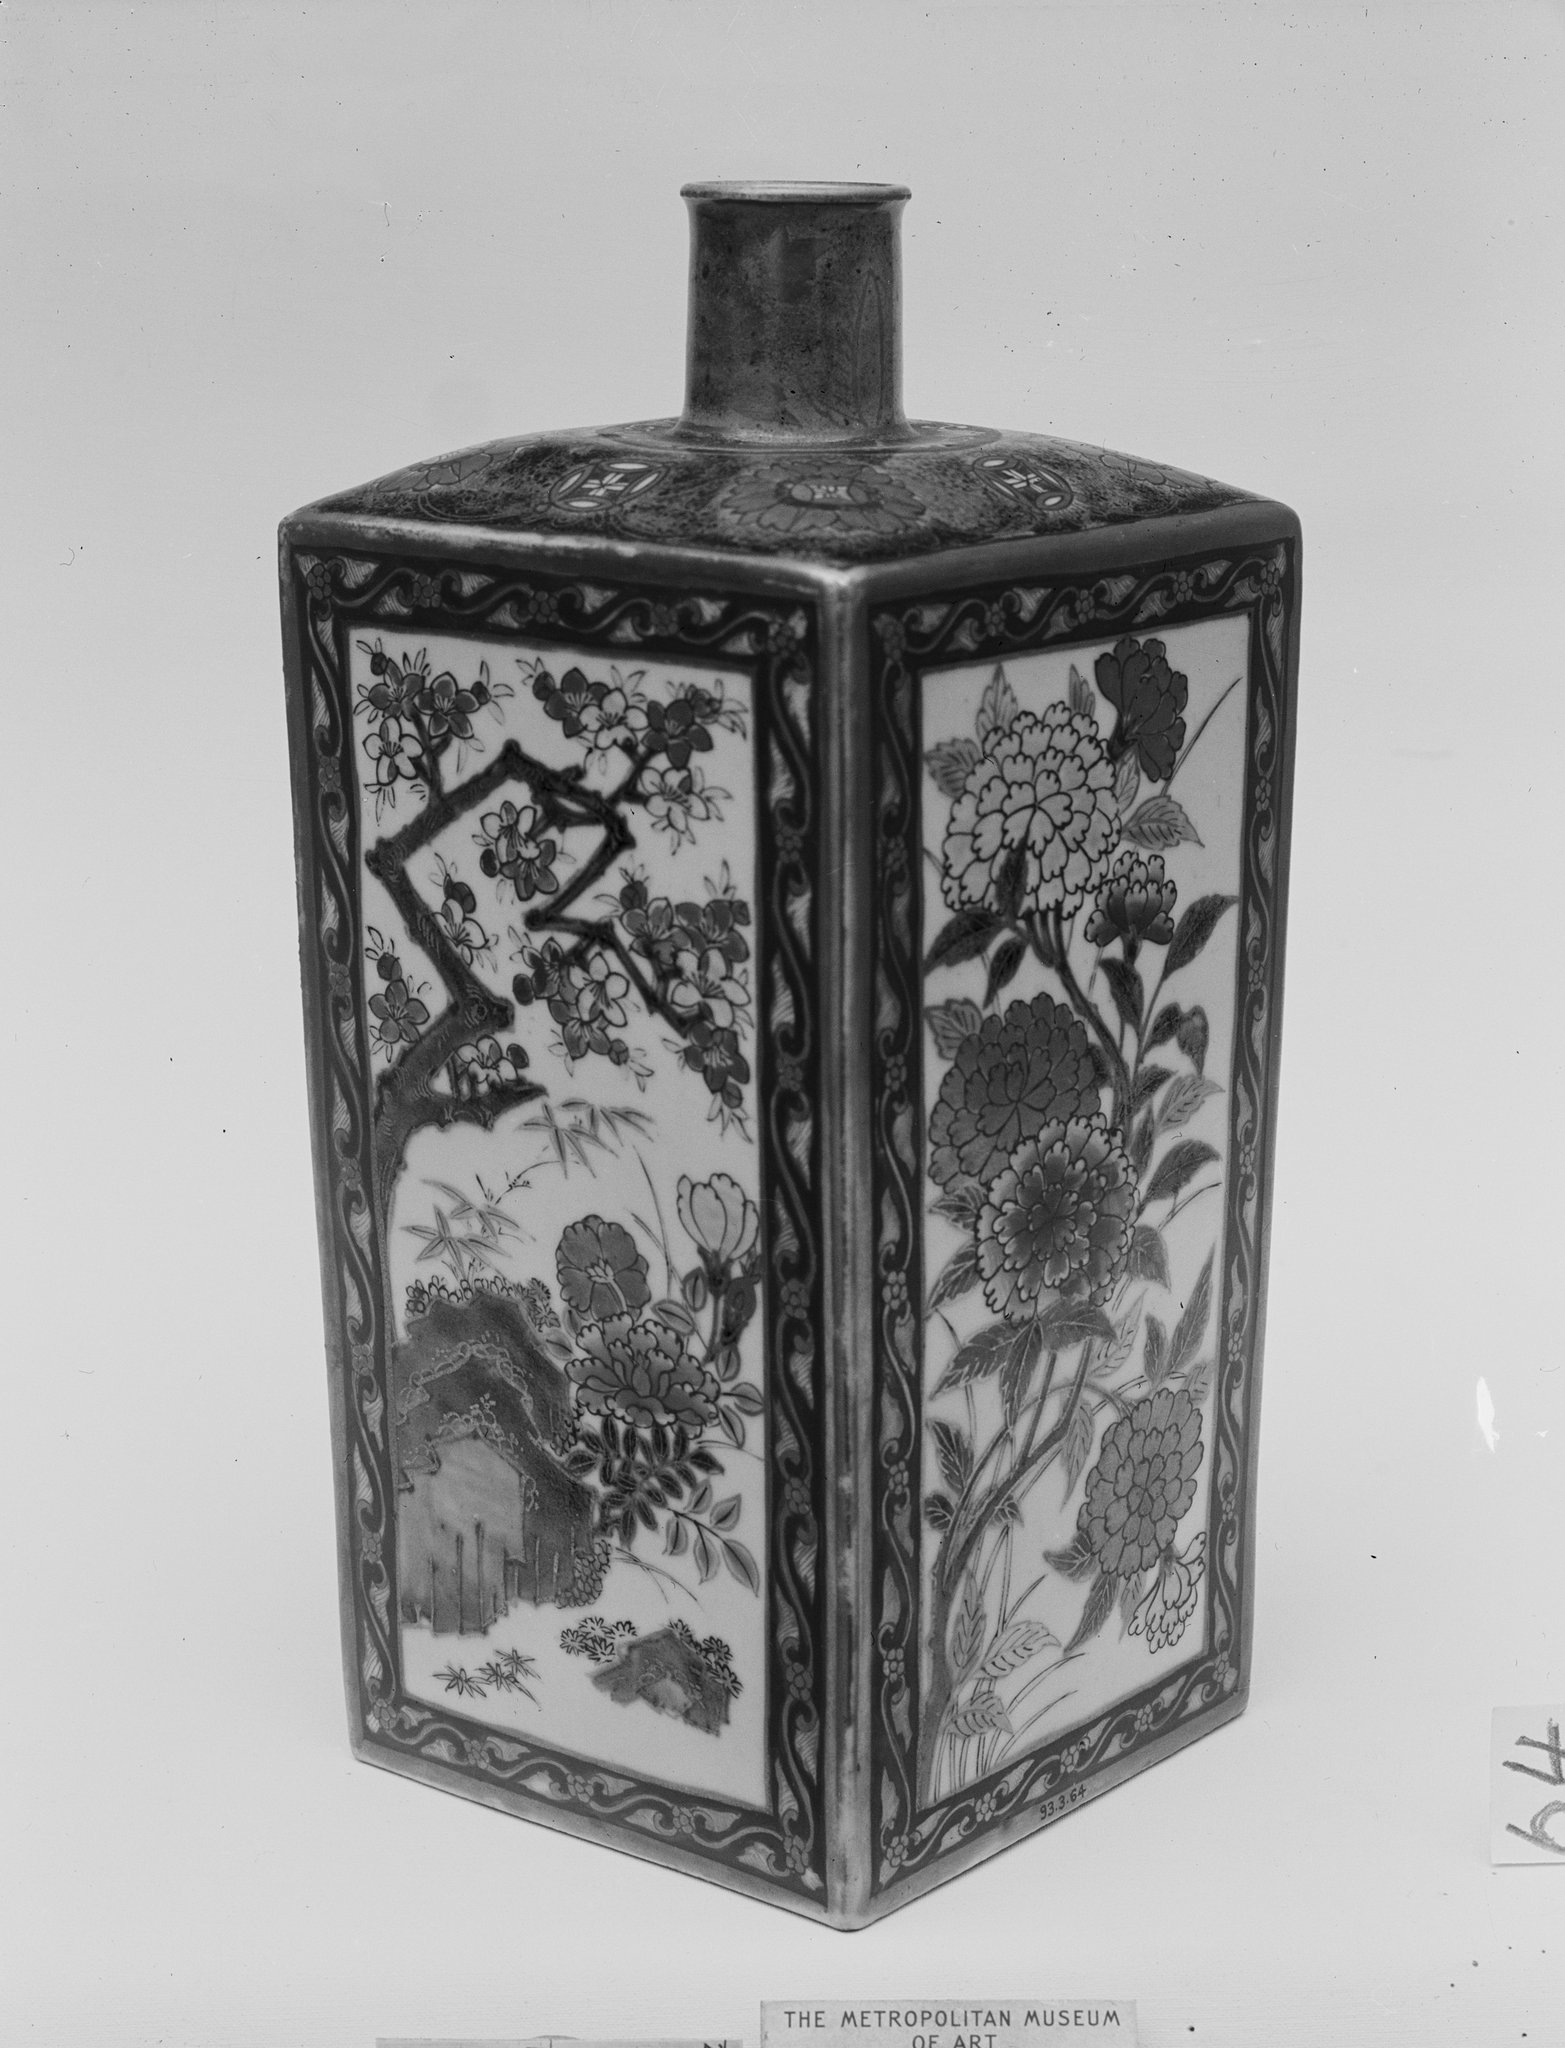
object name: bottle, square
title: Square Bottle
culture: japanese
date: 1750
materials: enamel, glaze, porcelain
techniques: polychrome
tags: flowers